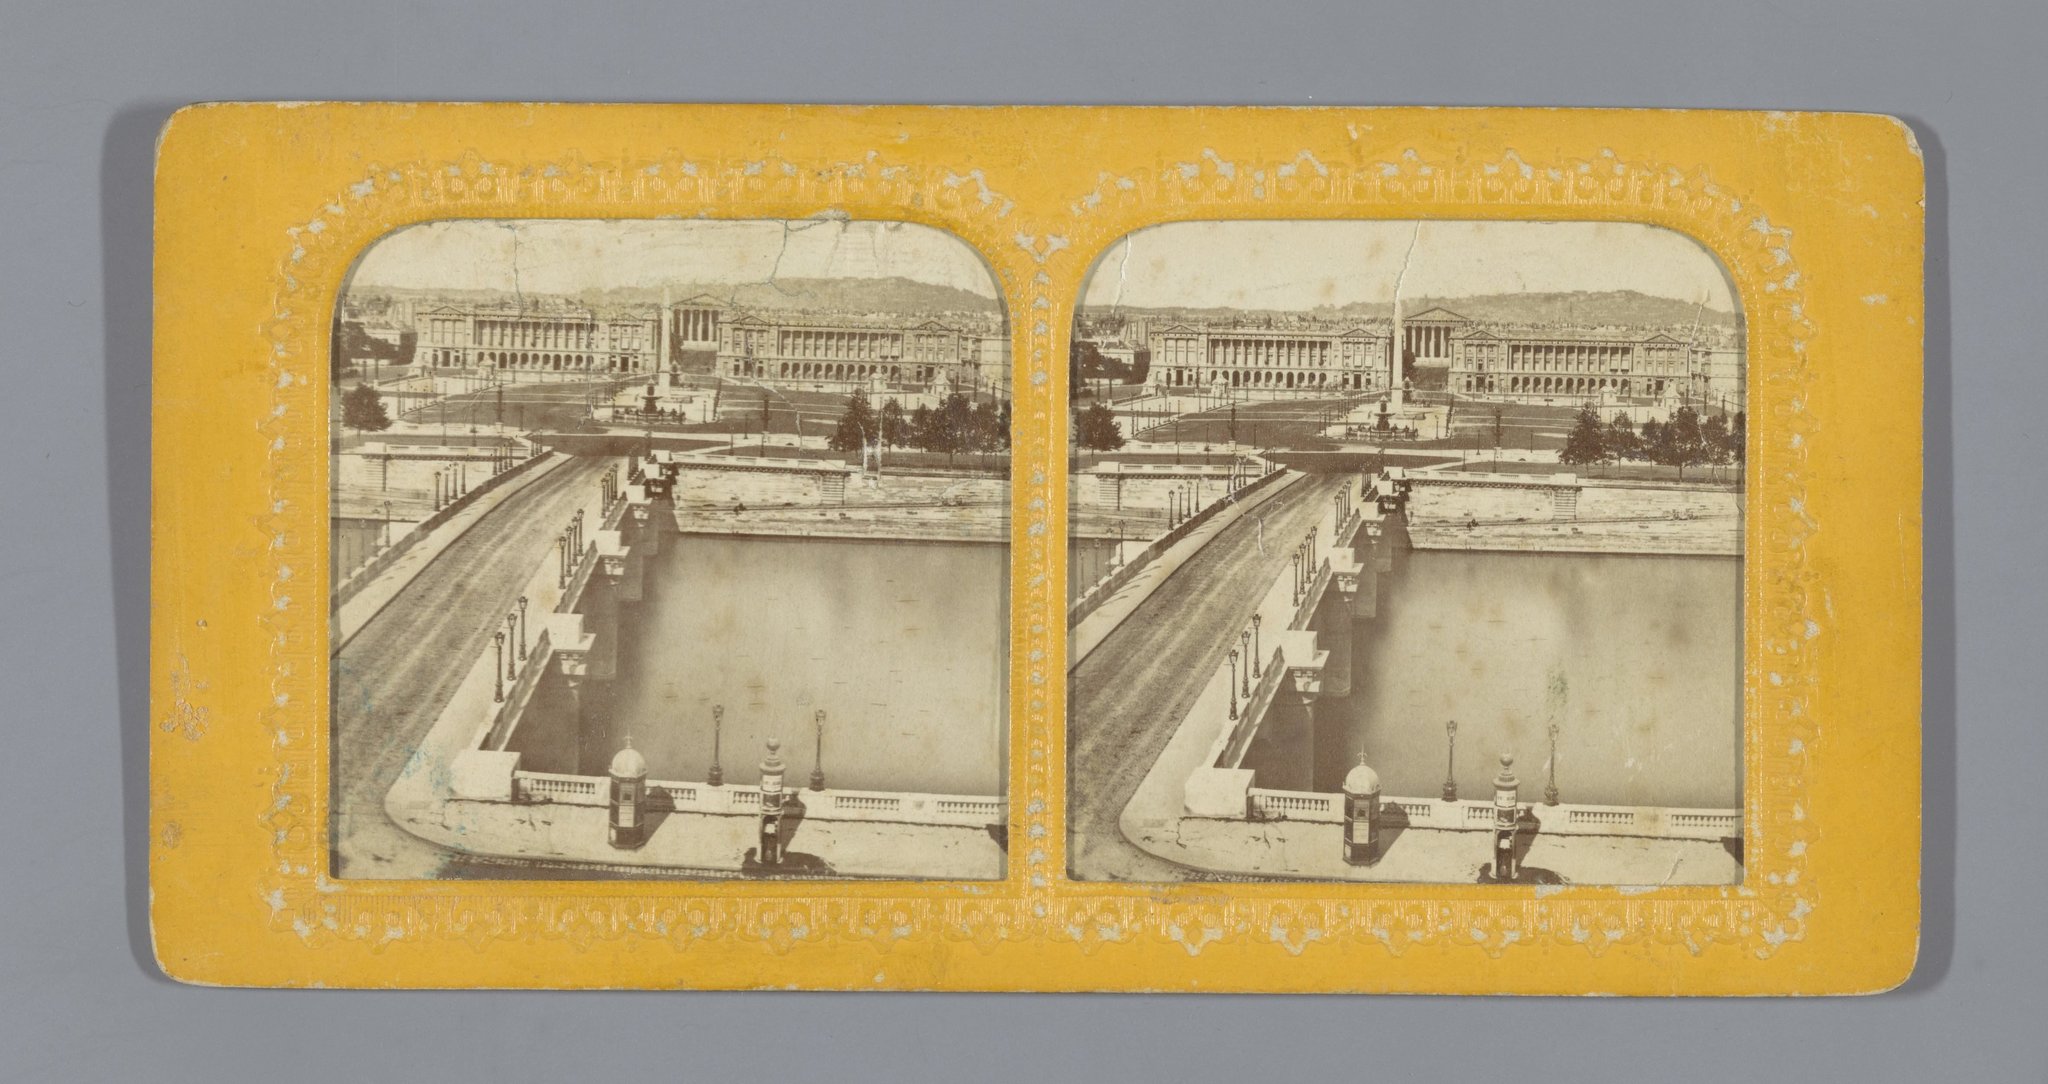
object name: tissue stereograph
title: Pont et Place de la Concorde, Paris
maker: Anonymous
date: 1855-1875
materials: cardboard, paper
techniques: albumen print, hand coloring, perforating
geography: paris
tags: square, place, circus, etc., bridge in city across river, canal, etc.